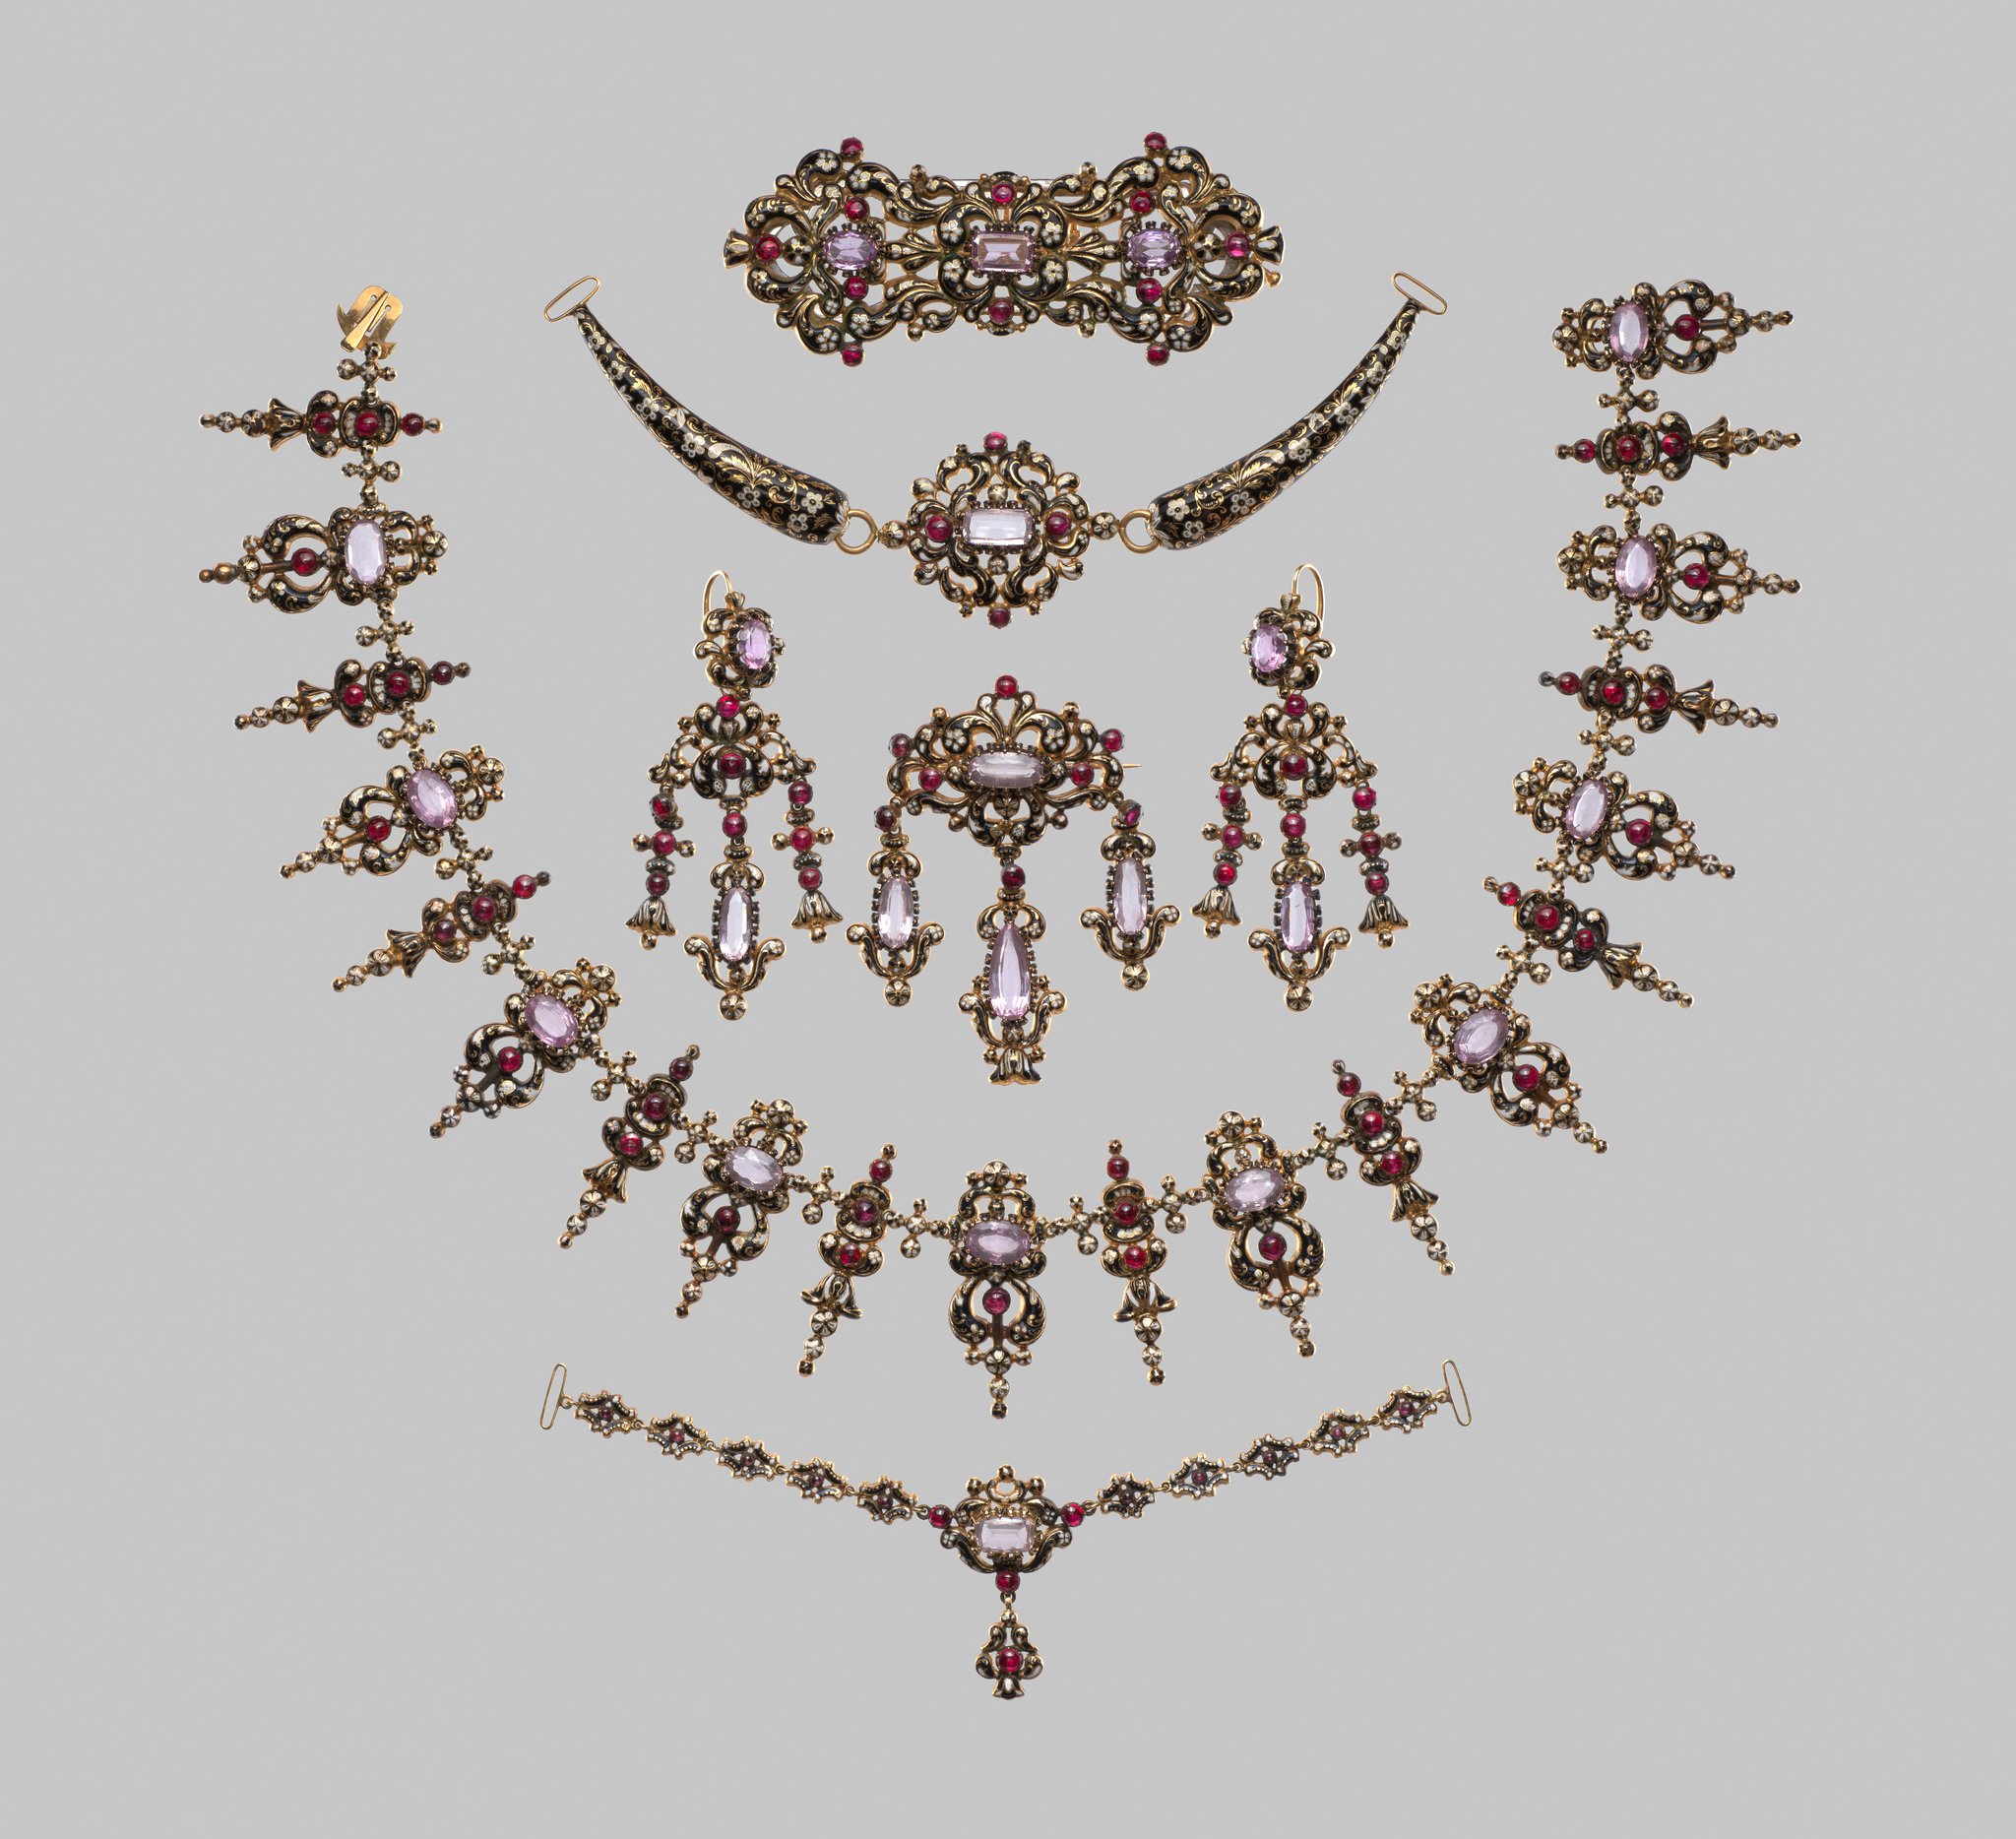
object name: parure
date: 1840-1850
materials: enamel, glass, gold, paste